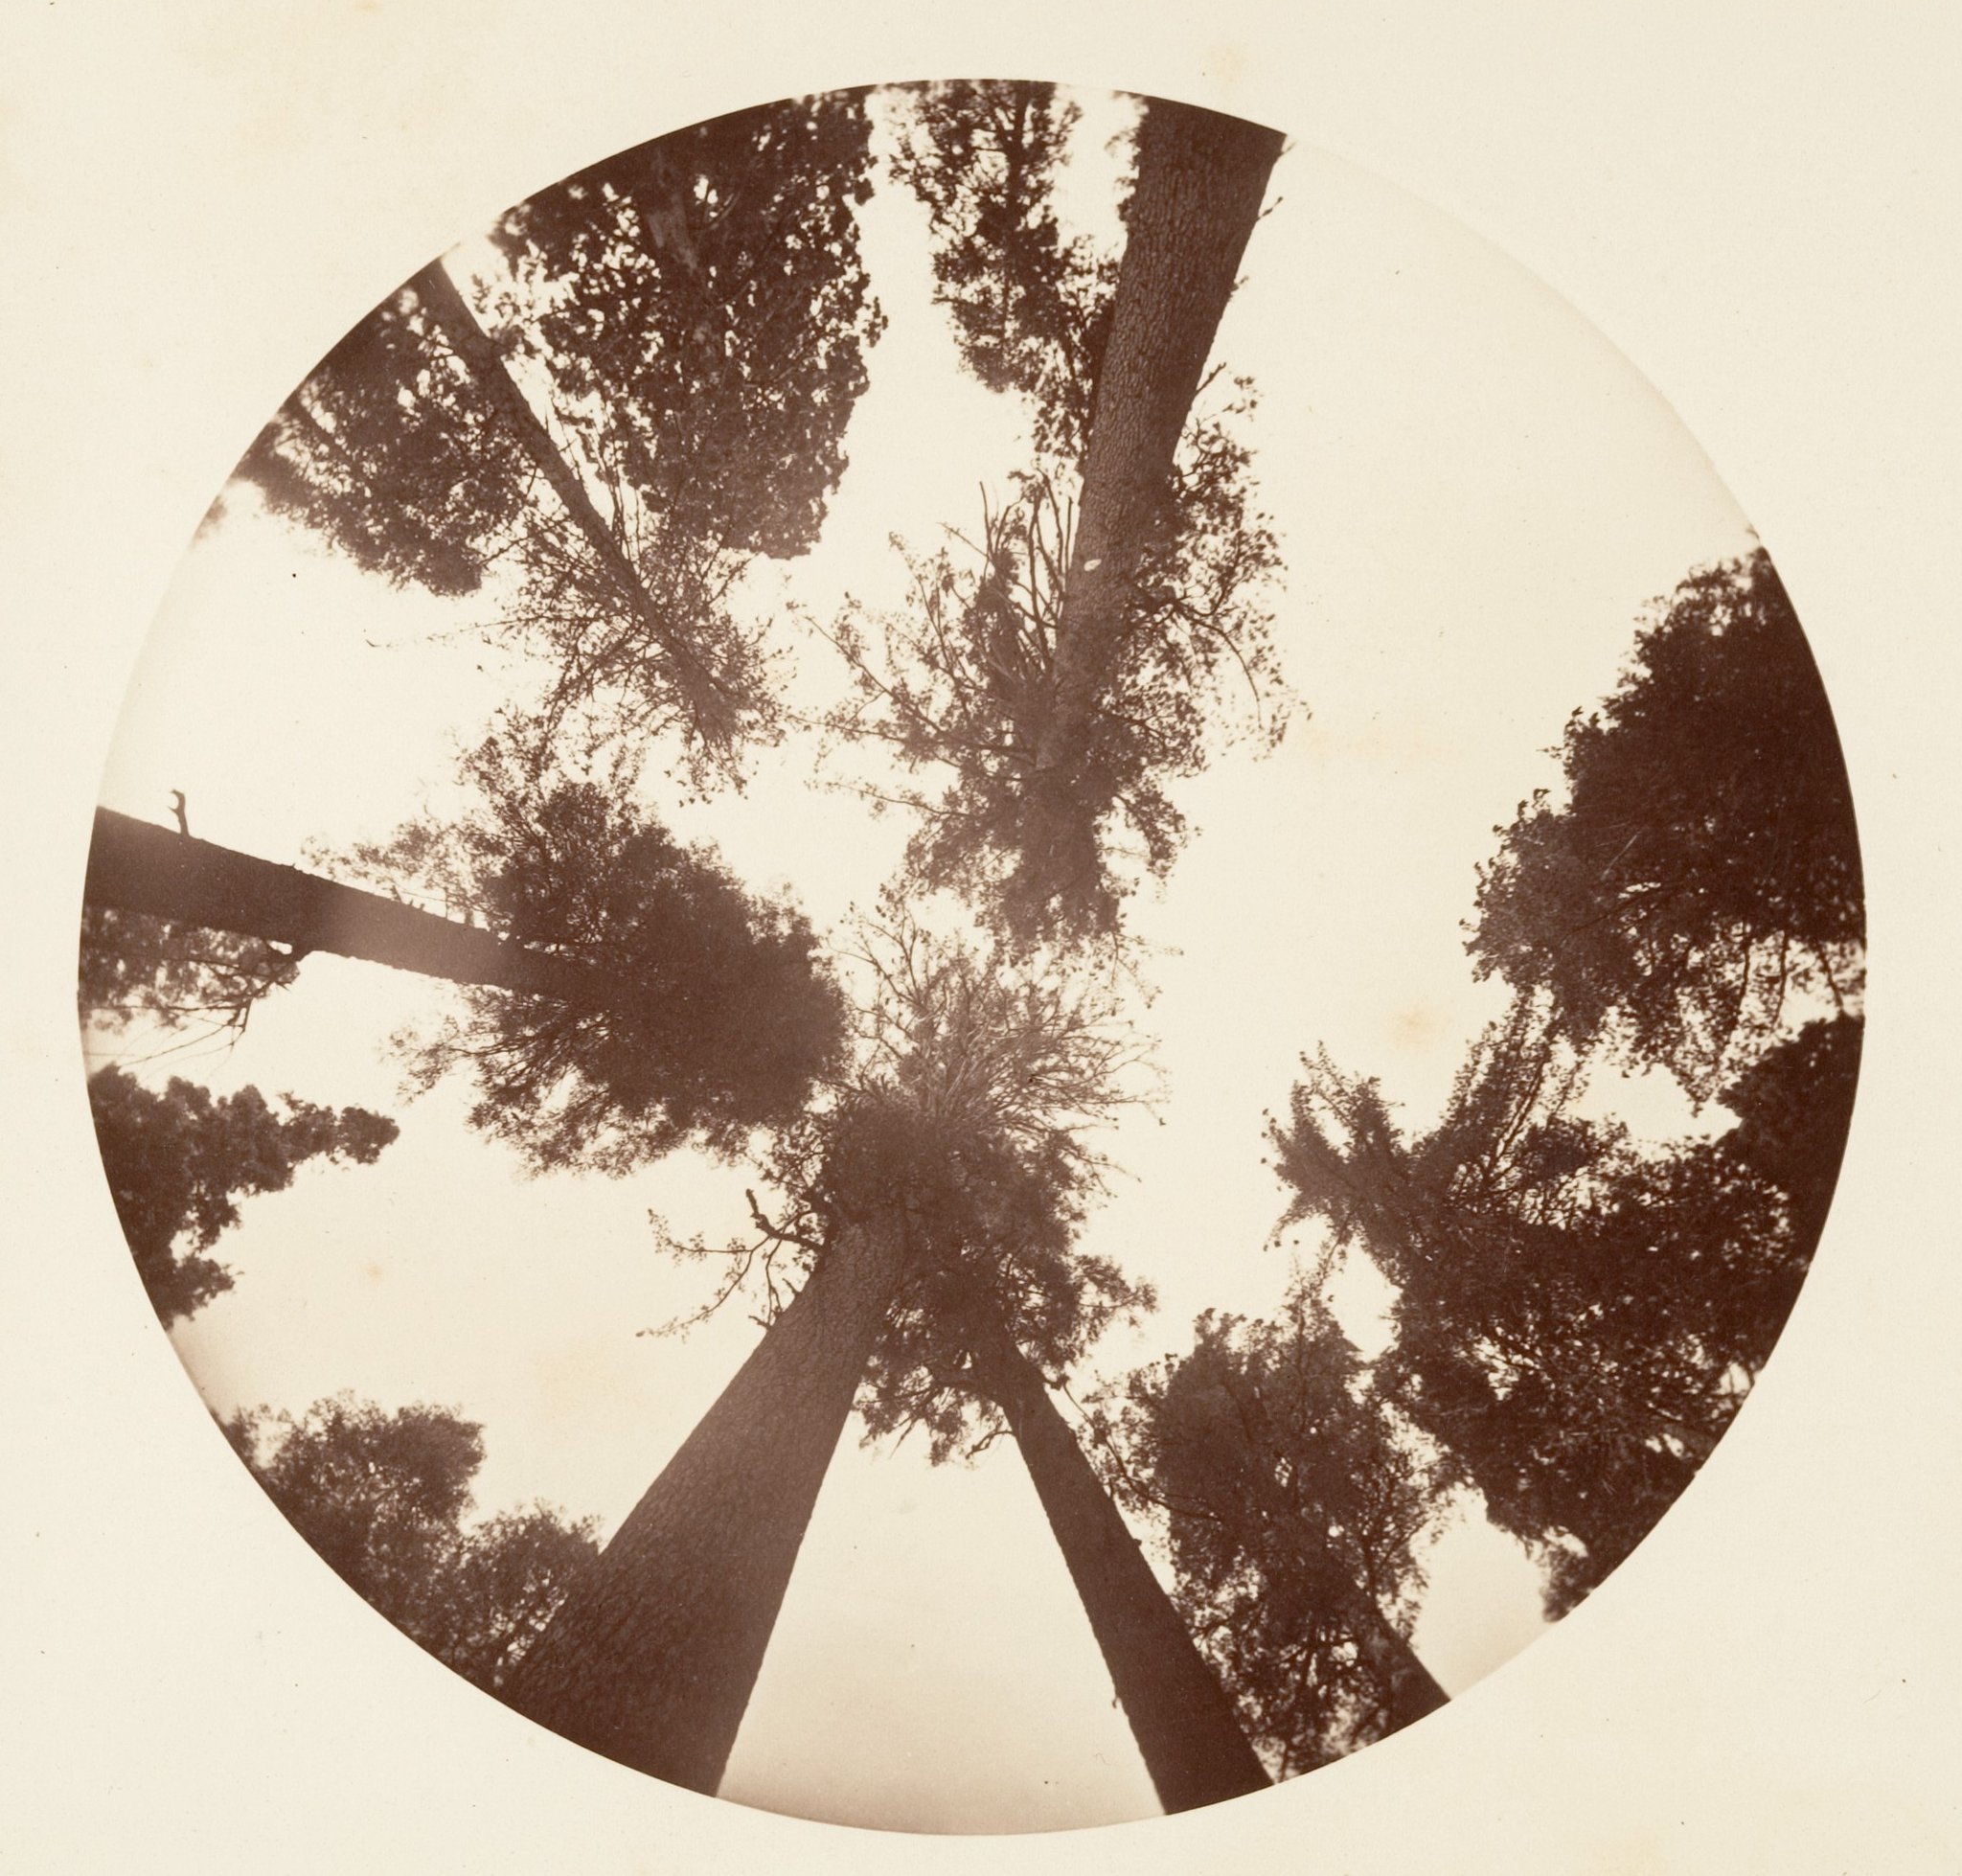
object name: photograph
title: Looking up Among the Sugar Pines - Calaveras Grove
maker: carleton e. watkins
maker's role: artist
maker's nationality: american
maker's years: 1829-1916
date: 1878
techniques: albumen silver print, glass negative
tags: trees